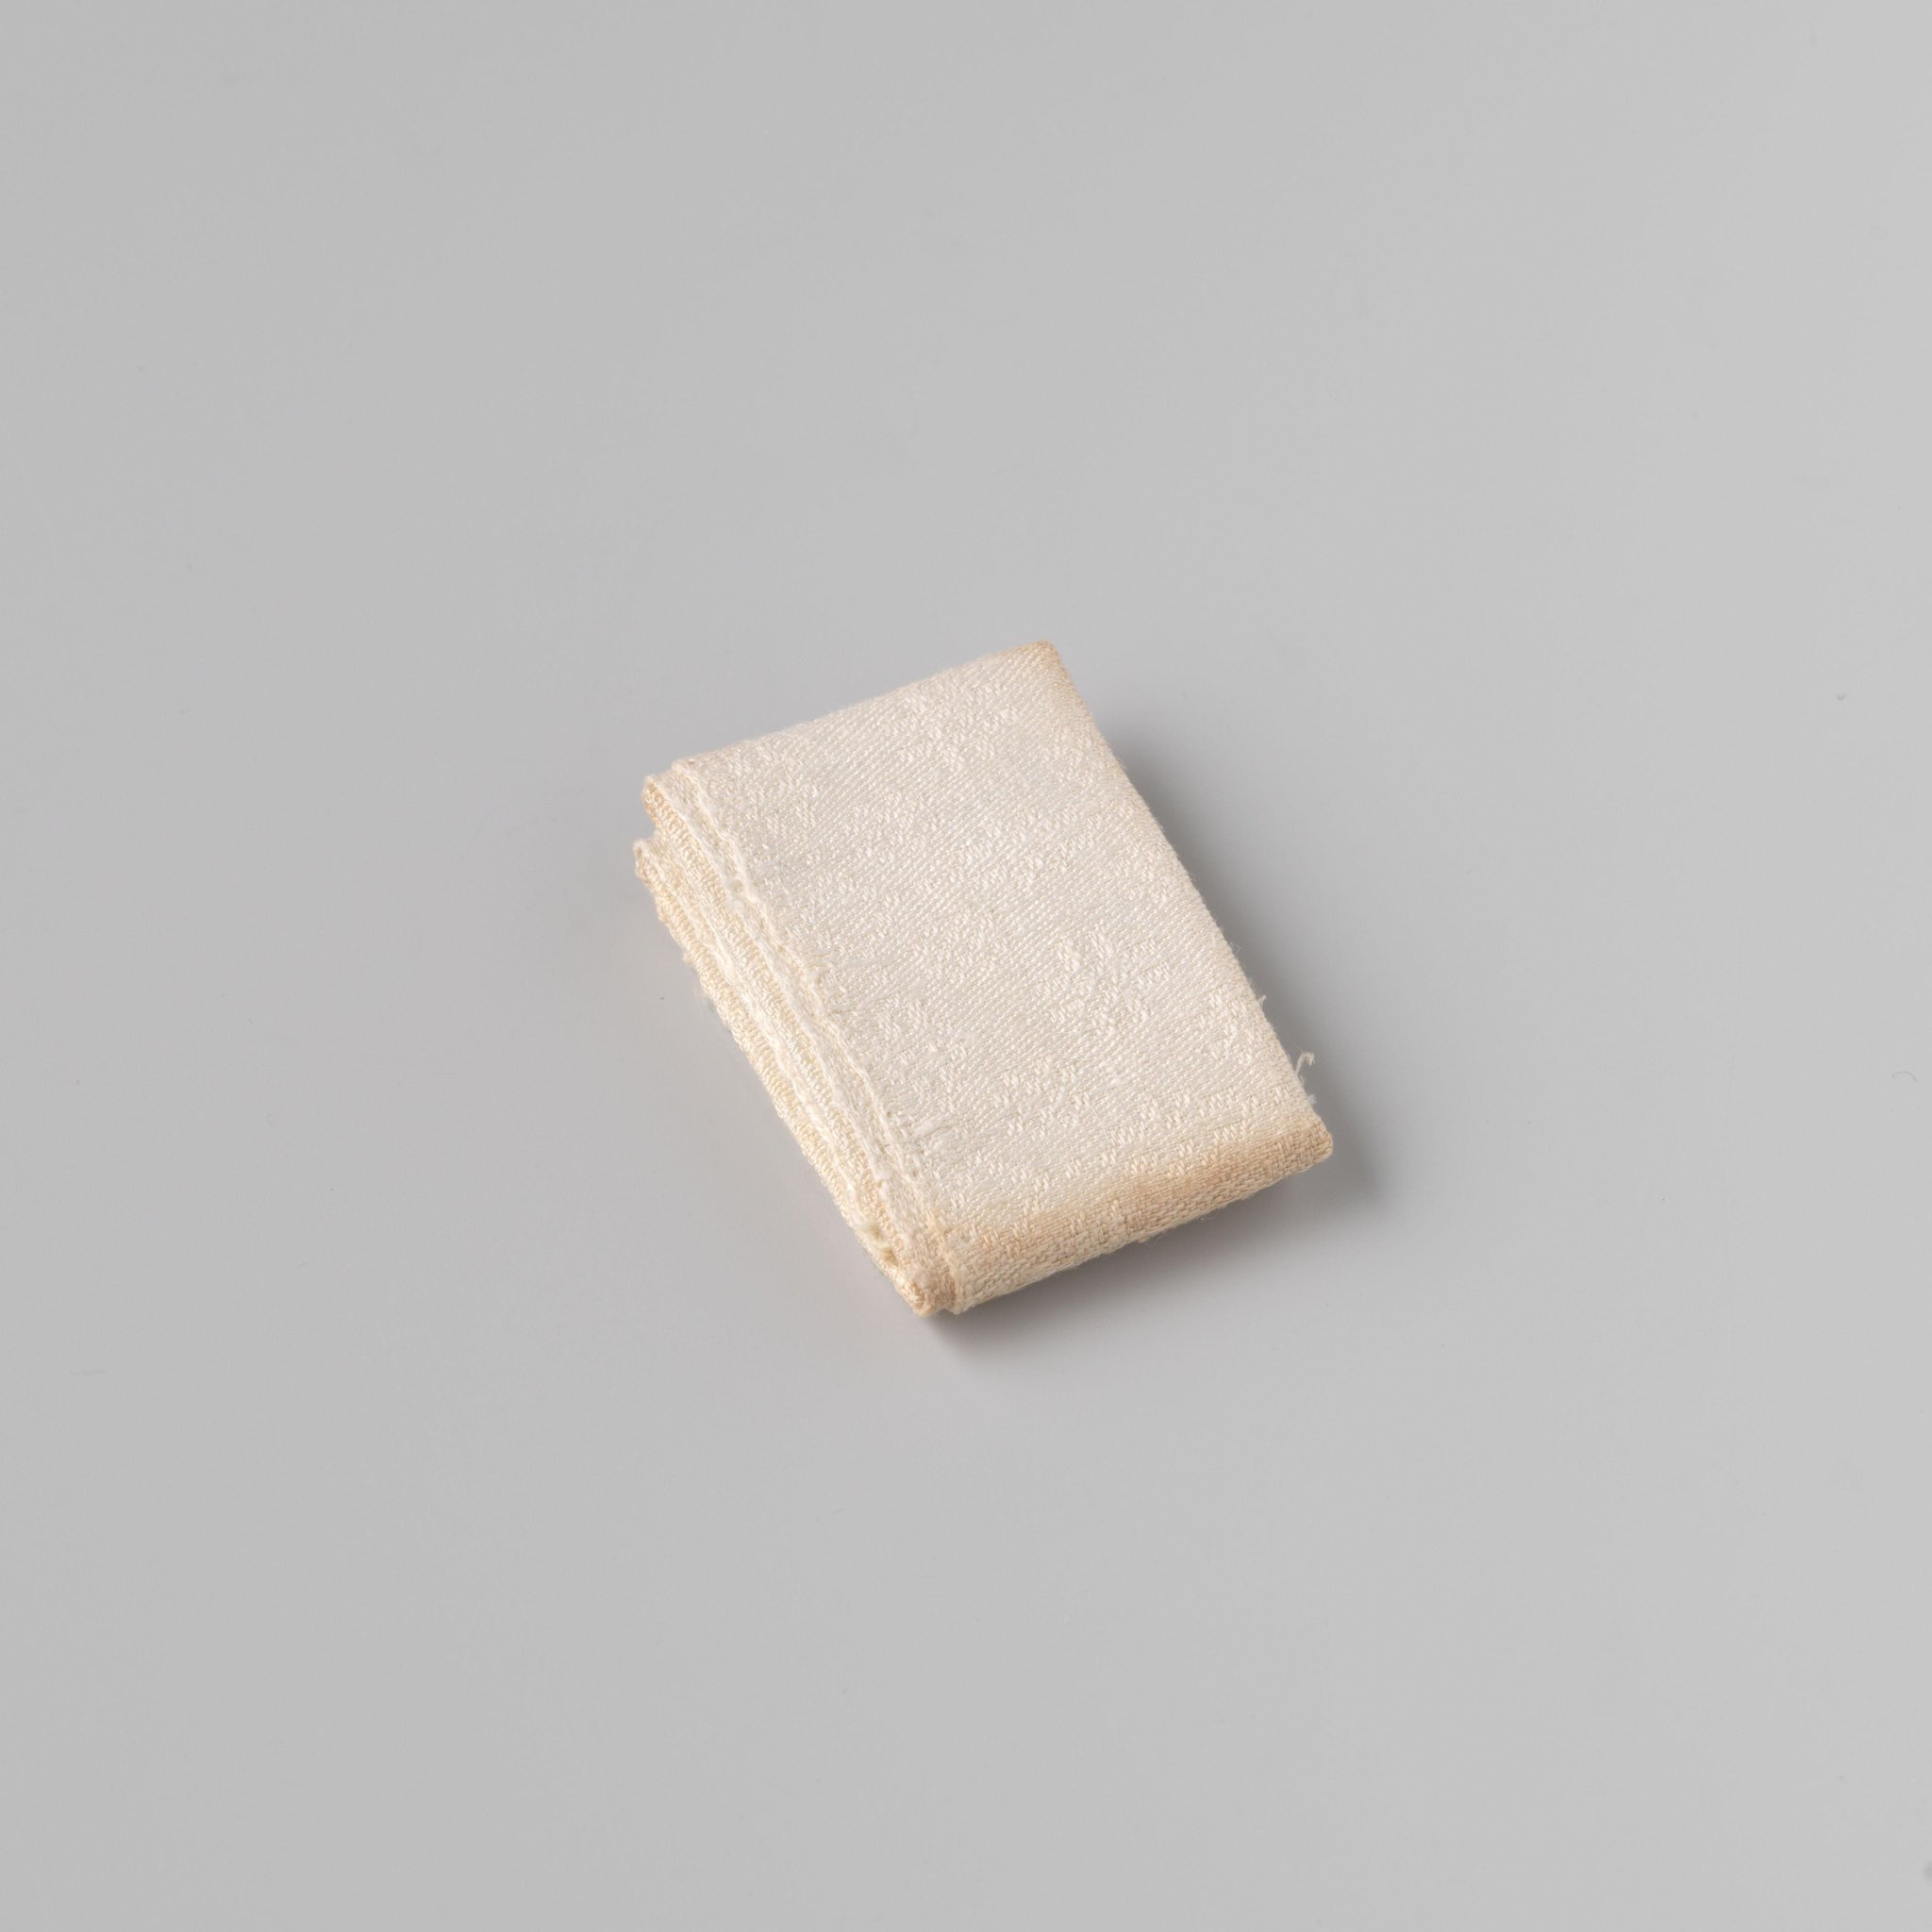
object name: napkin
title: Linnen servet van damastweefsel met pellenpatroon (motief I), geen zomen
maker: Anonymous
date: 1690-1710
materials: linen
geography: amsterdam